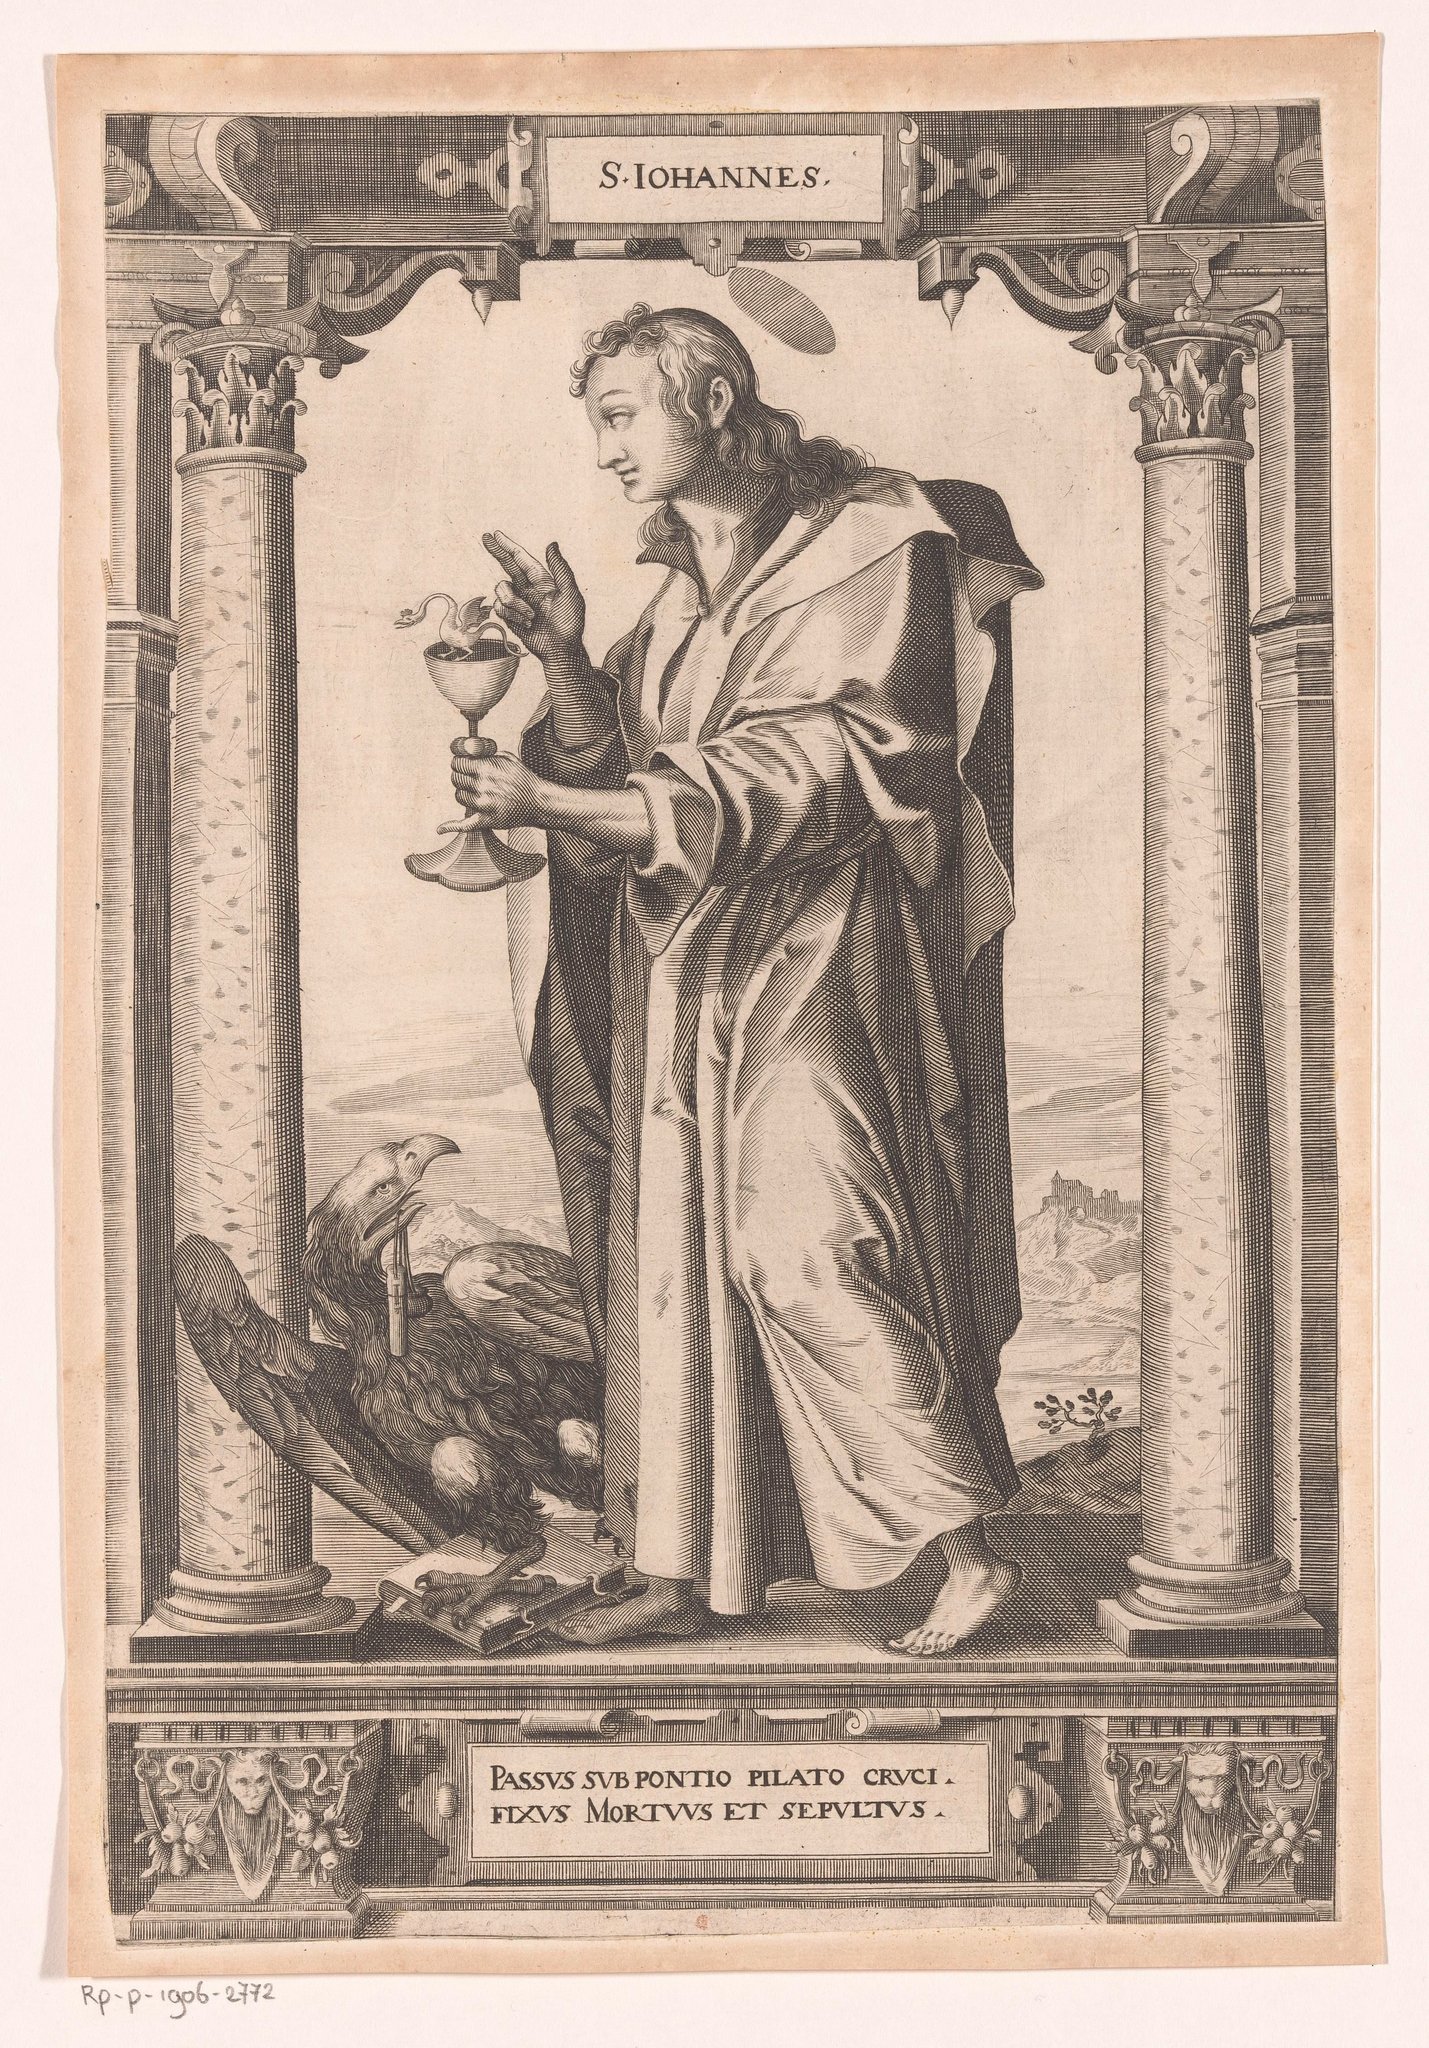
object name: print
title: S. Iohannes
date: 1614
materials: paper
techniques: engraving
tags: the apostle john the evangelist; possible attributes: book, cauldron, chalice with snake, eagle, palm, scroll - portrait of male saint, architectural detail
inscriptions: collector's mark: Lugt 2228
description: Onderdeel van een serie van veertien prenten. Vervaardigingsdetails vermeld op de eerste prent.